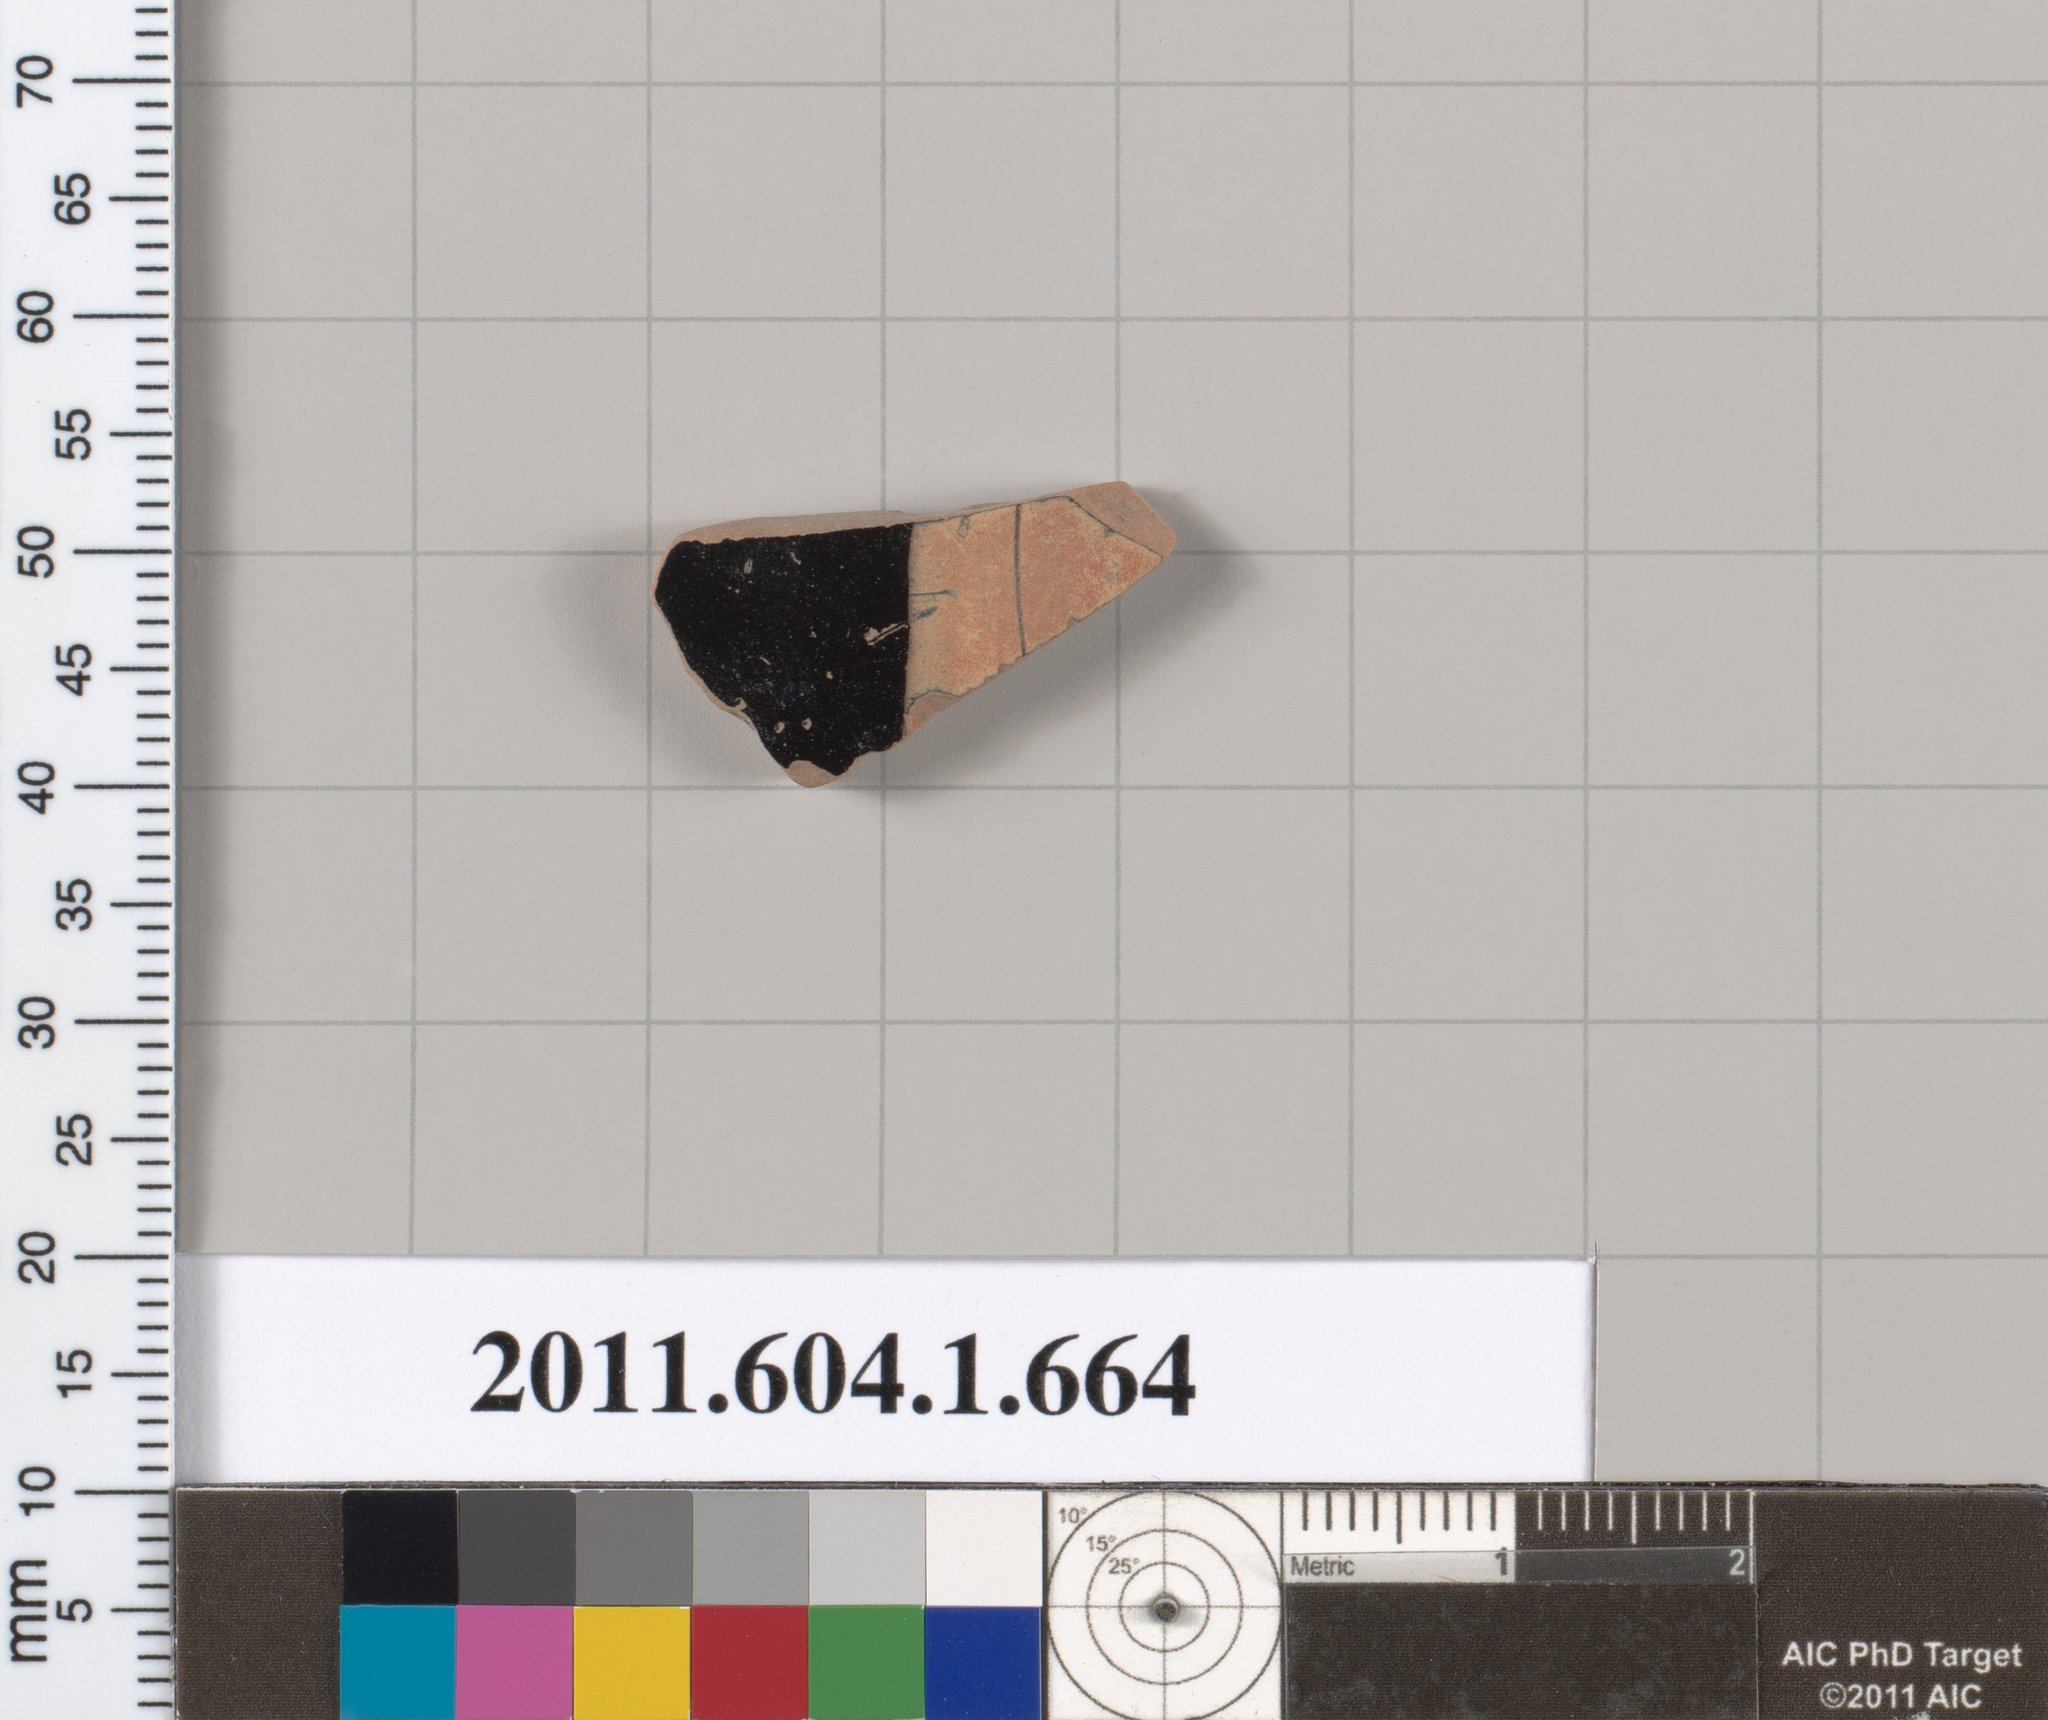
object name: kylix fragment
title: Terracotta fragment of a kylix (drinking cup)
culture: greek, attic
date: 475-451 BCE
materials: terracotta